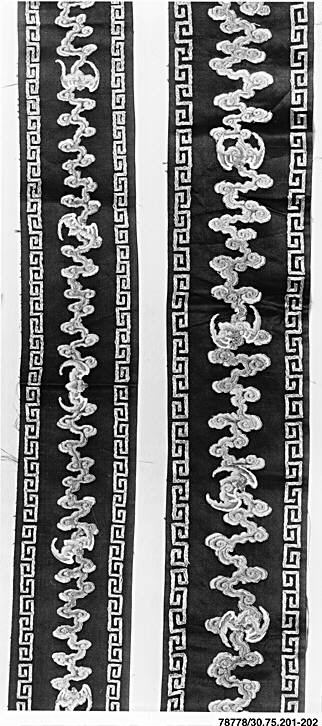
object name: trimming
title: Trimming Bands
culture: chinese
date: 1801-1900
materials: metal thread, silk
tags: bats